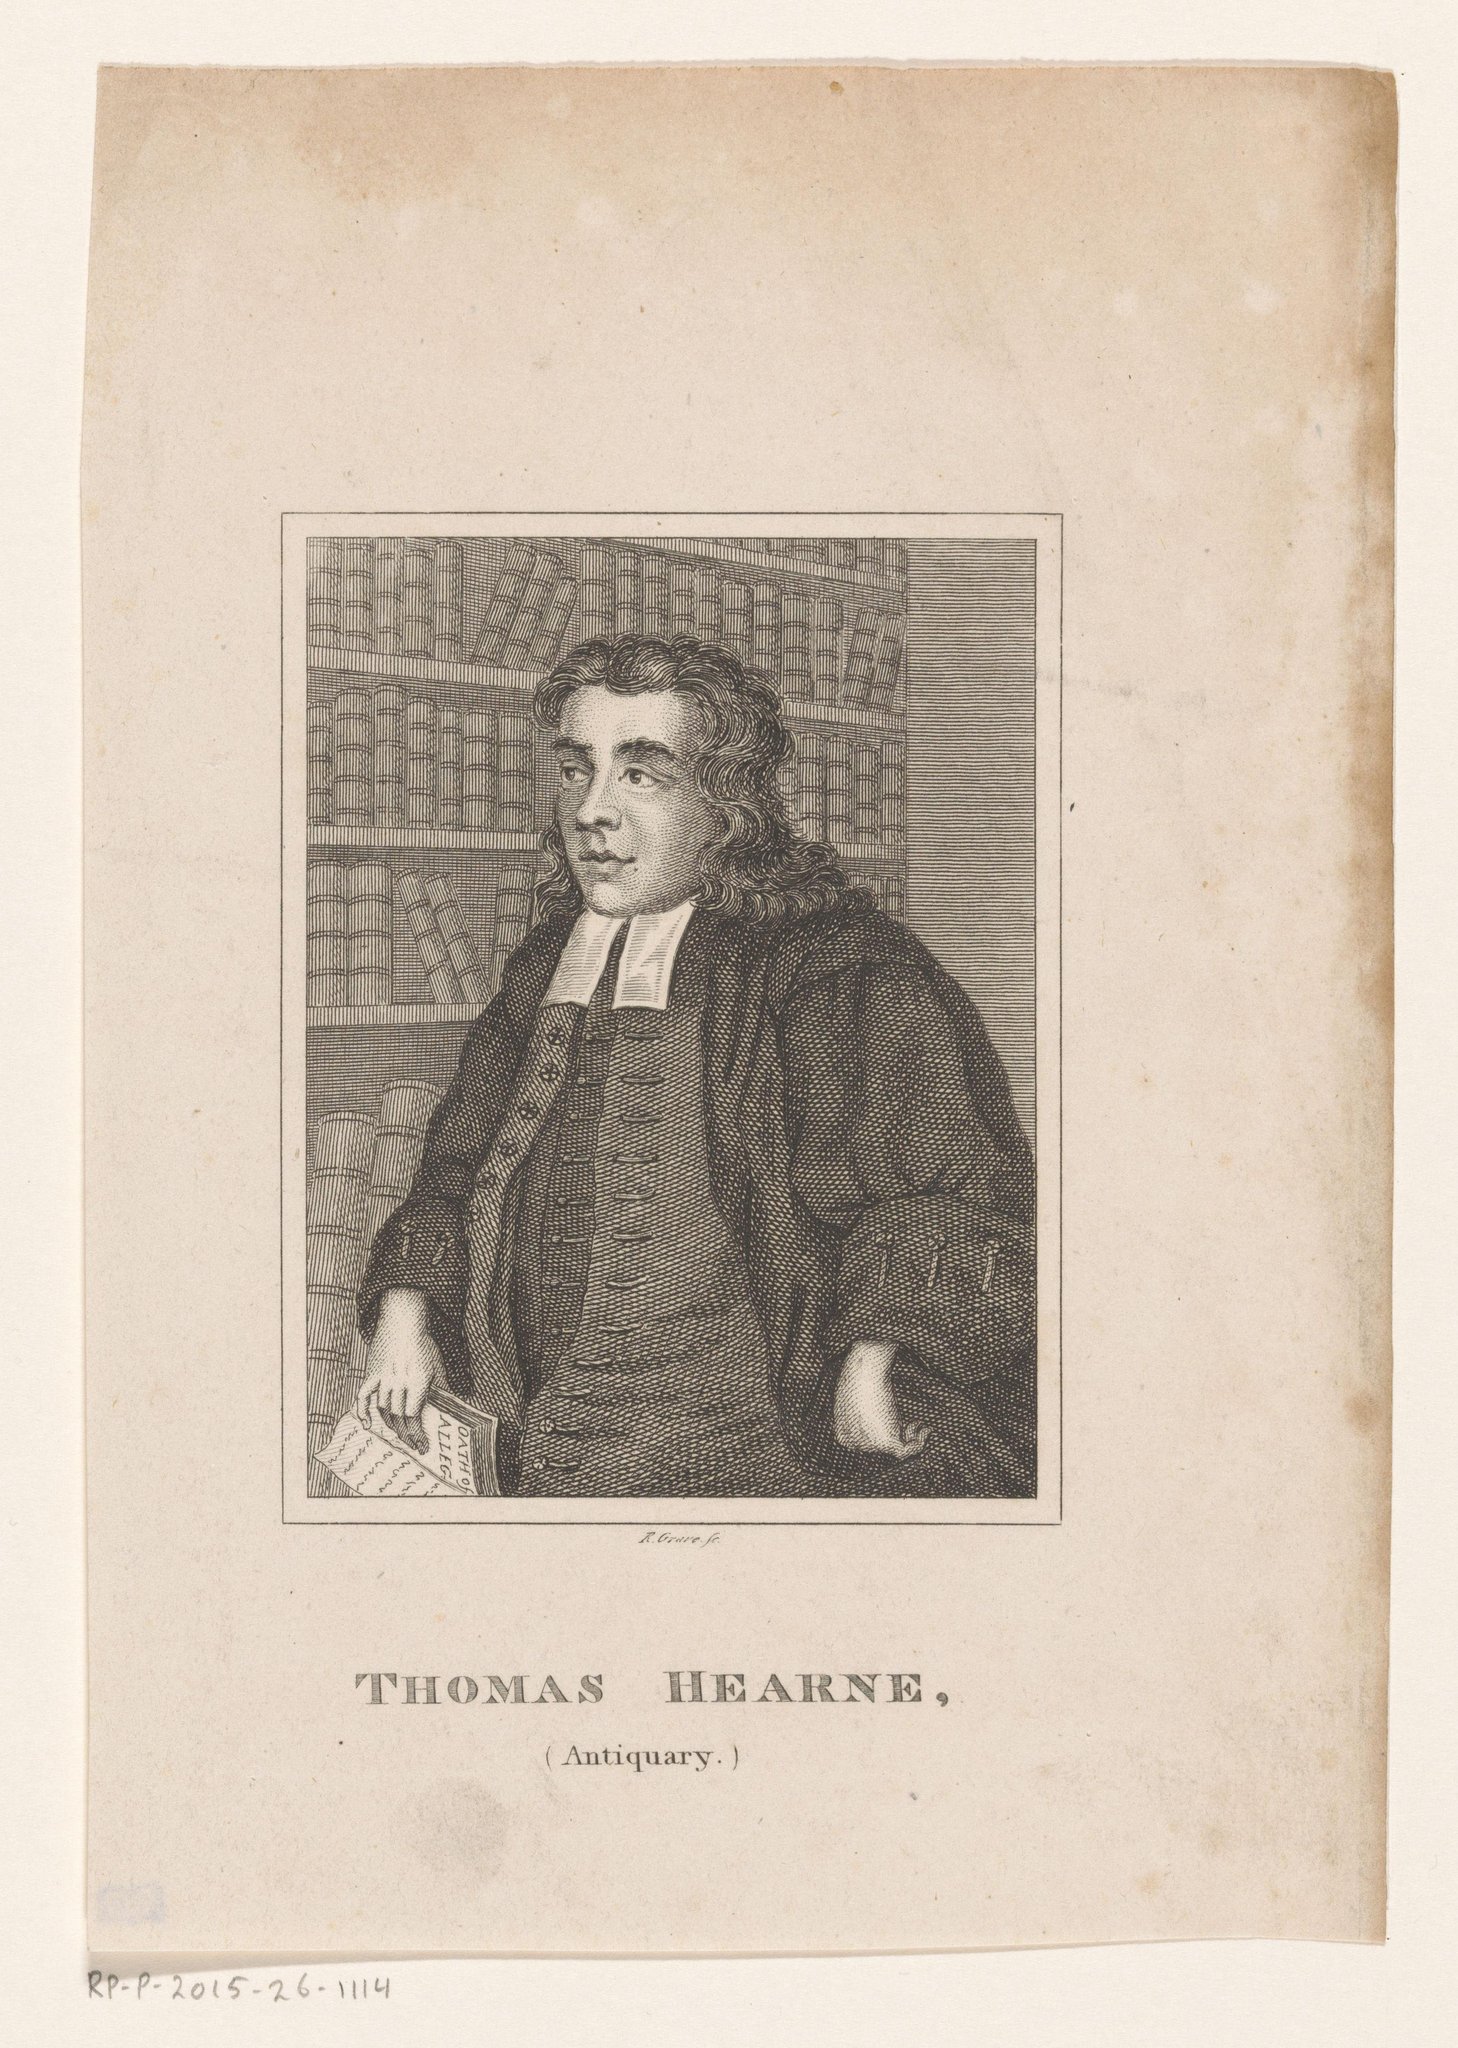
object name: print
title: Thomas Hearne, (Antiquary)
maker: robert graves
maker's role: print maker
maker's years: 1798-1873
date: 1808-1873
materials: paper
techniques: etching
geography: london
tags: london, print maker, thomas hearne, scholar in his study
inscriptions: collector's mark: Lugt 2228, collector's mark: Lugt 4780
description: Thomas Hearne voor een boekenkast met in zijn rechterhand een geopend boek, getiteld: 'Oath of Alleg[iance]'.